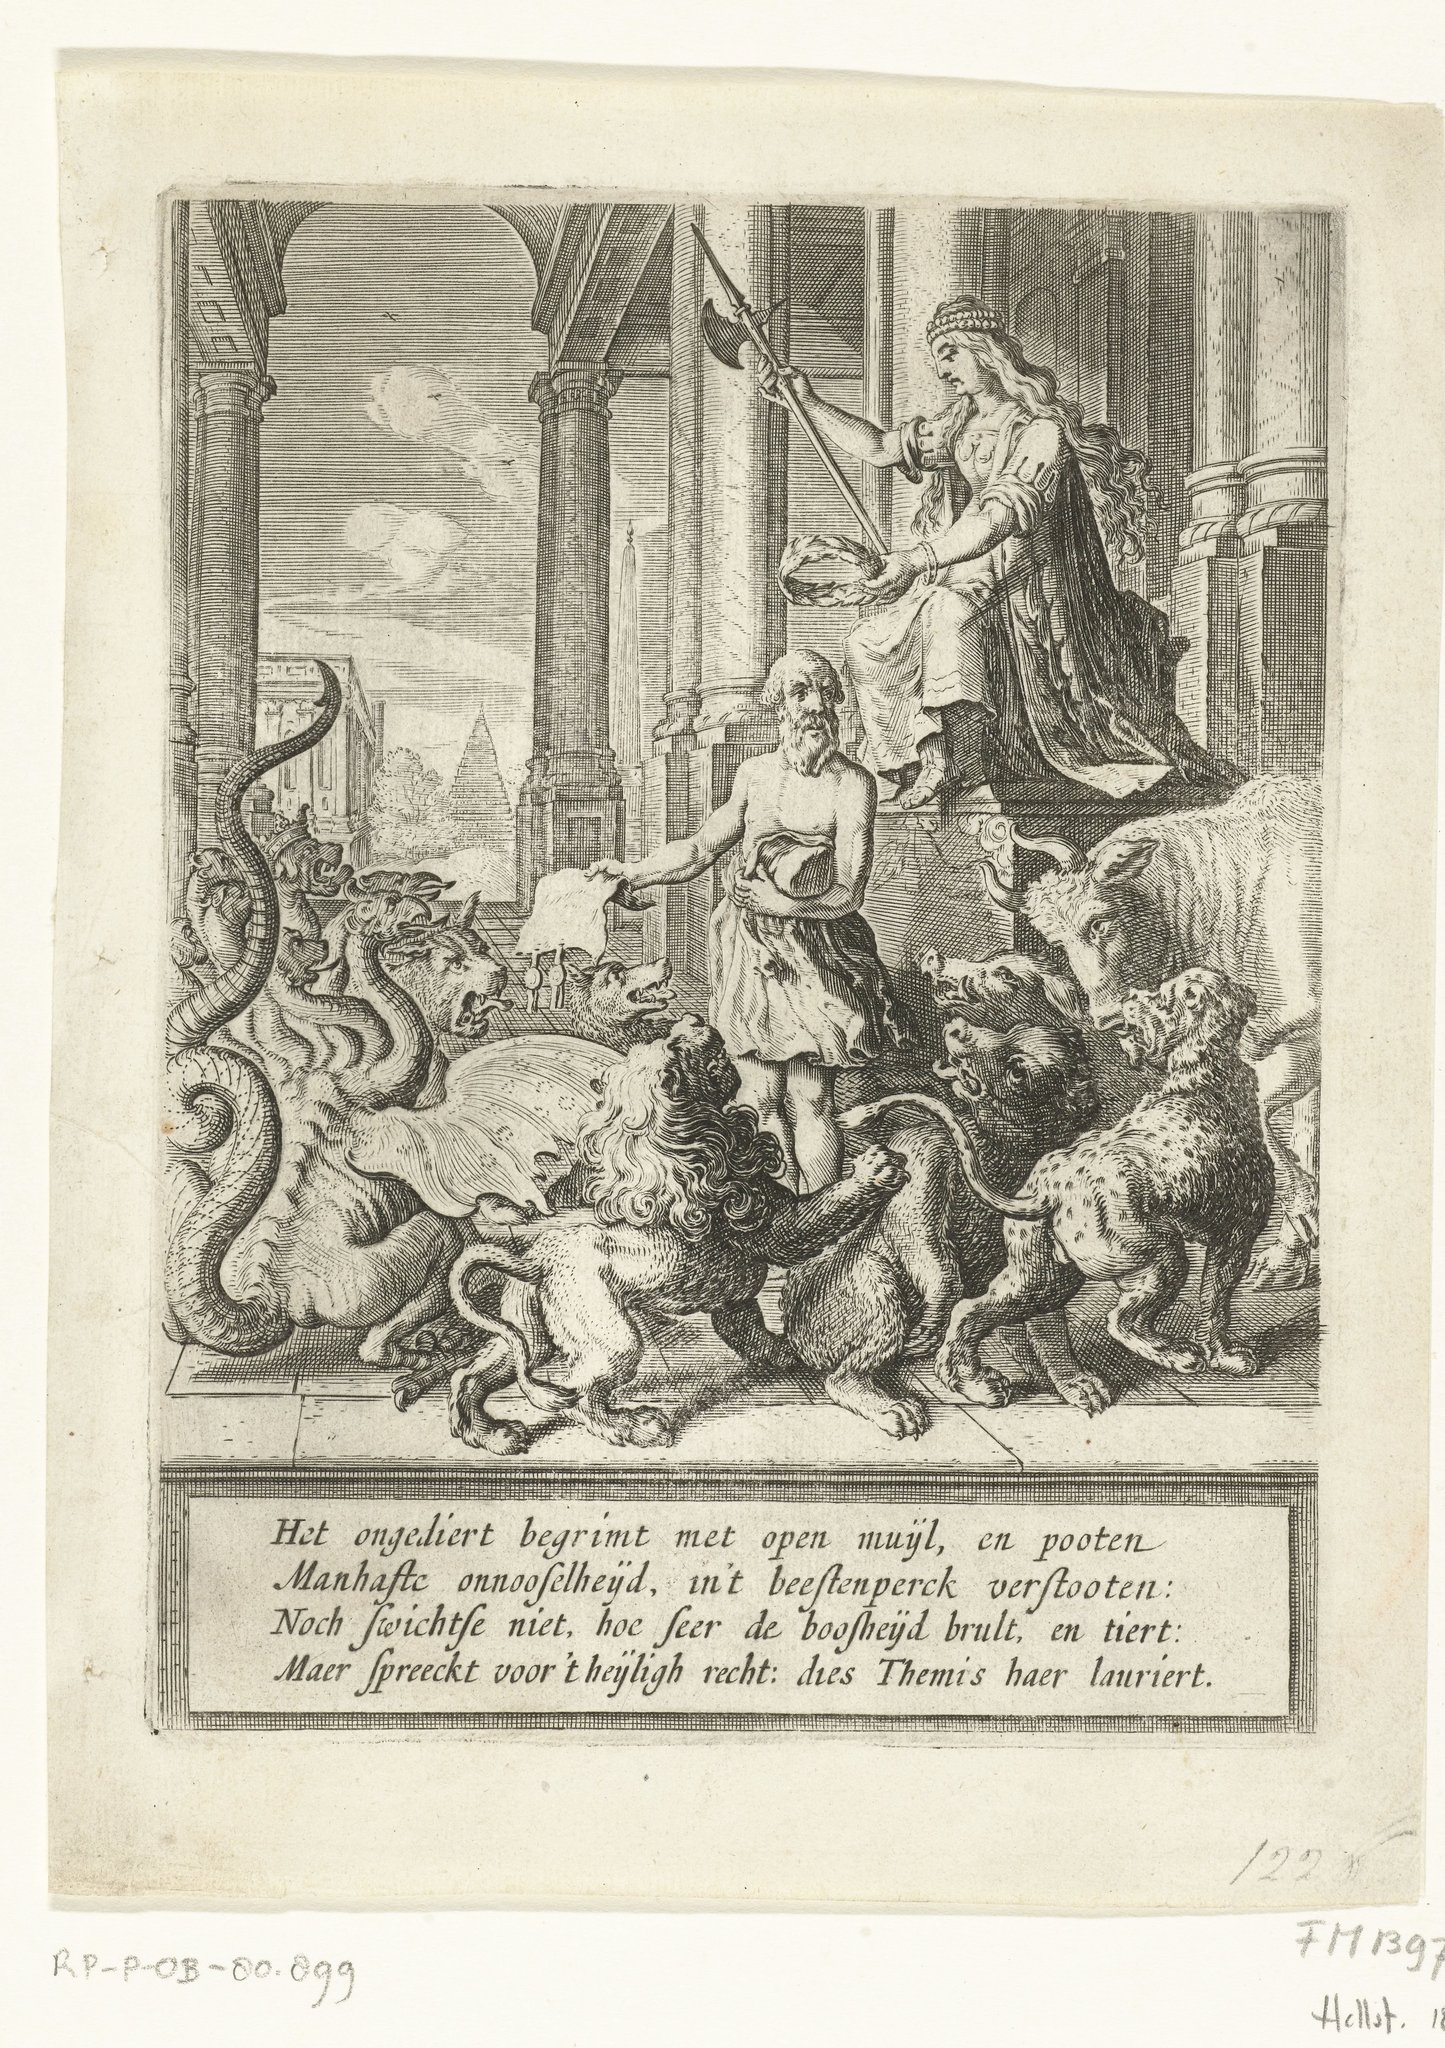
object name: print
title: Allegorische titelprent voor Vondels Palamedes, 1625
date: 1623-1625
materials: paper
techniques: engraving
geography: northern netherlands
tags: johan van oldenbarnevelt, maurice (prince of orange), title-page, themis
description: Allegorische titelprent voor Vondels treurspel Palamedes, 1625. Staande oude man lijkend op Johan van Oldenbarnevelt met privilege in de hand, omringd door allerlei woeste dieren. Rechts Themis (godin van de Rechtvaardigheid) die een lauwerkrans boven het hoofd van de man houdt. Onder de voorstelling een cartouche met vers van 4 regels in het Nederlands.